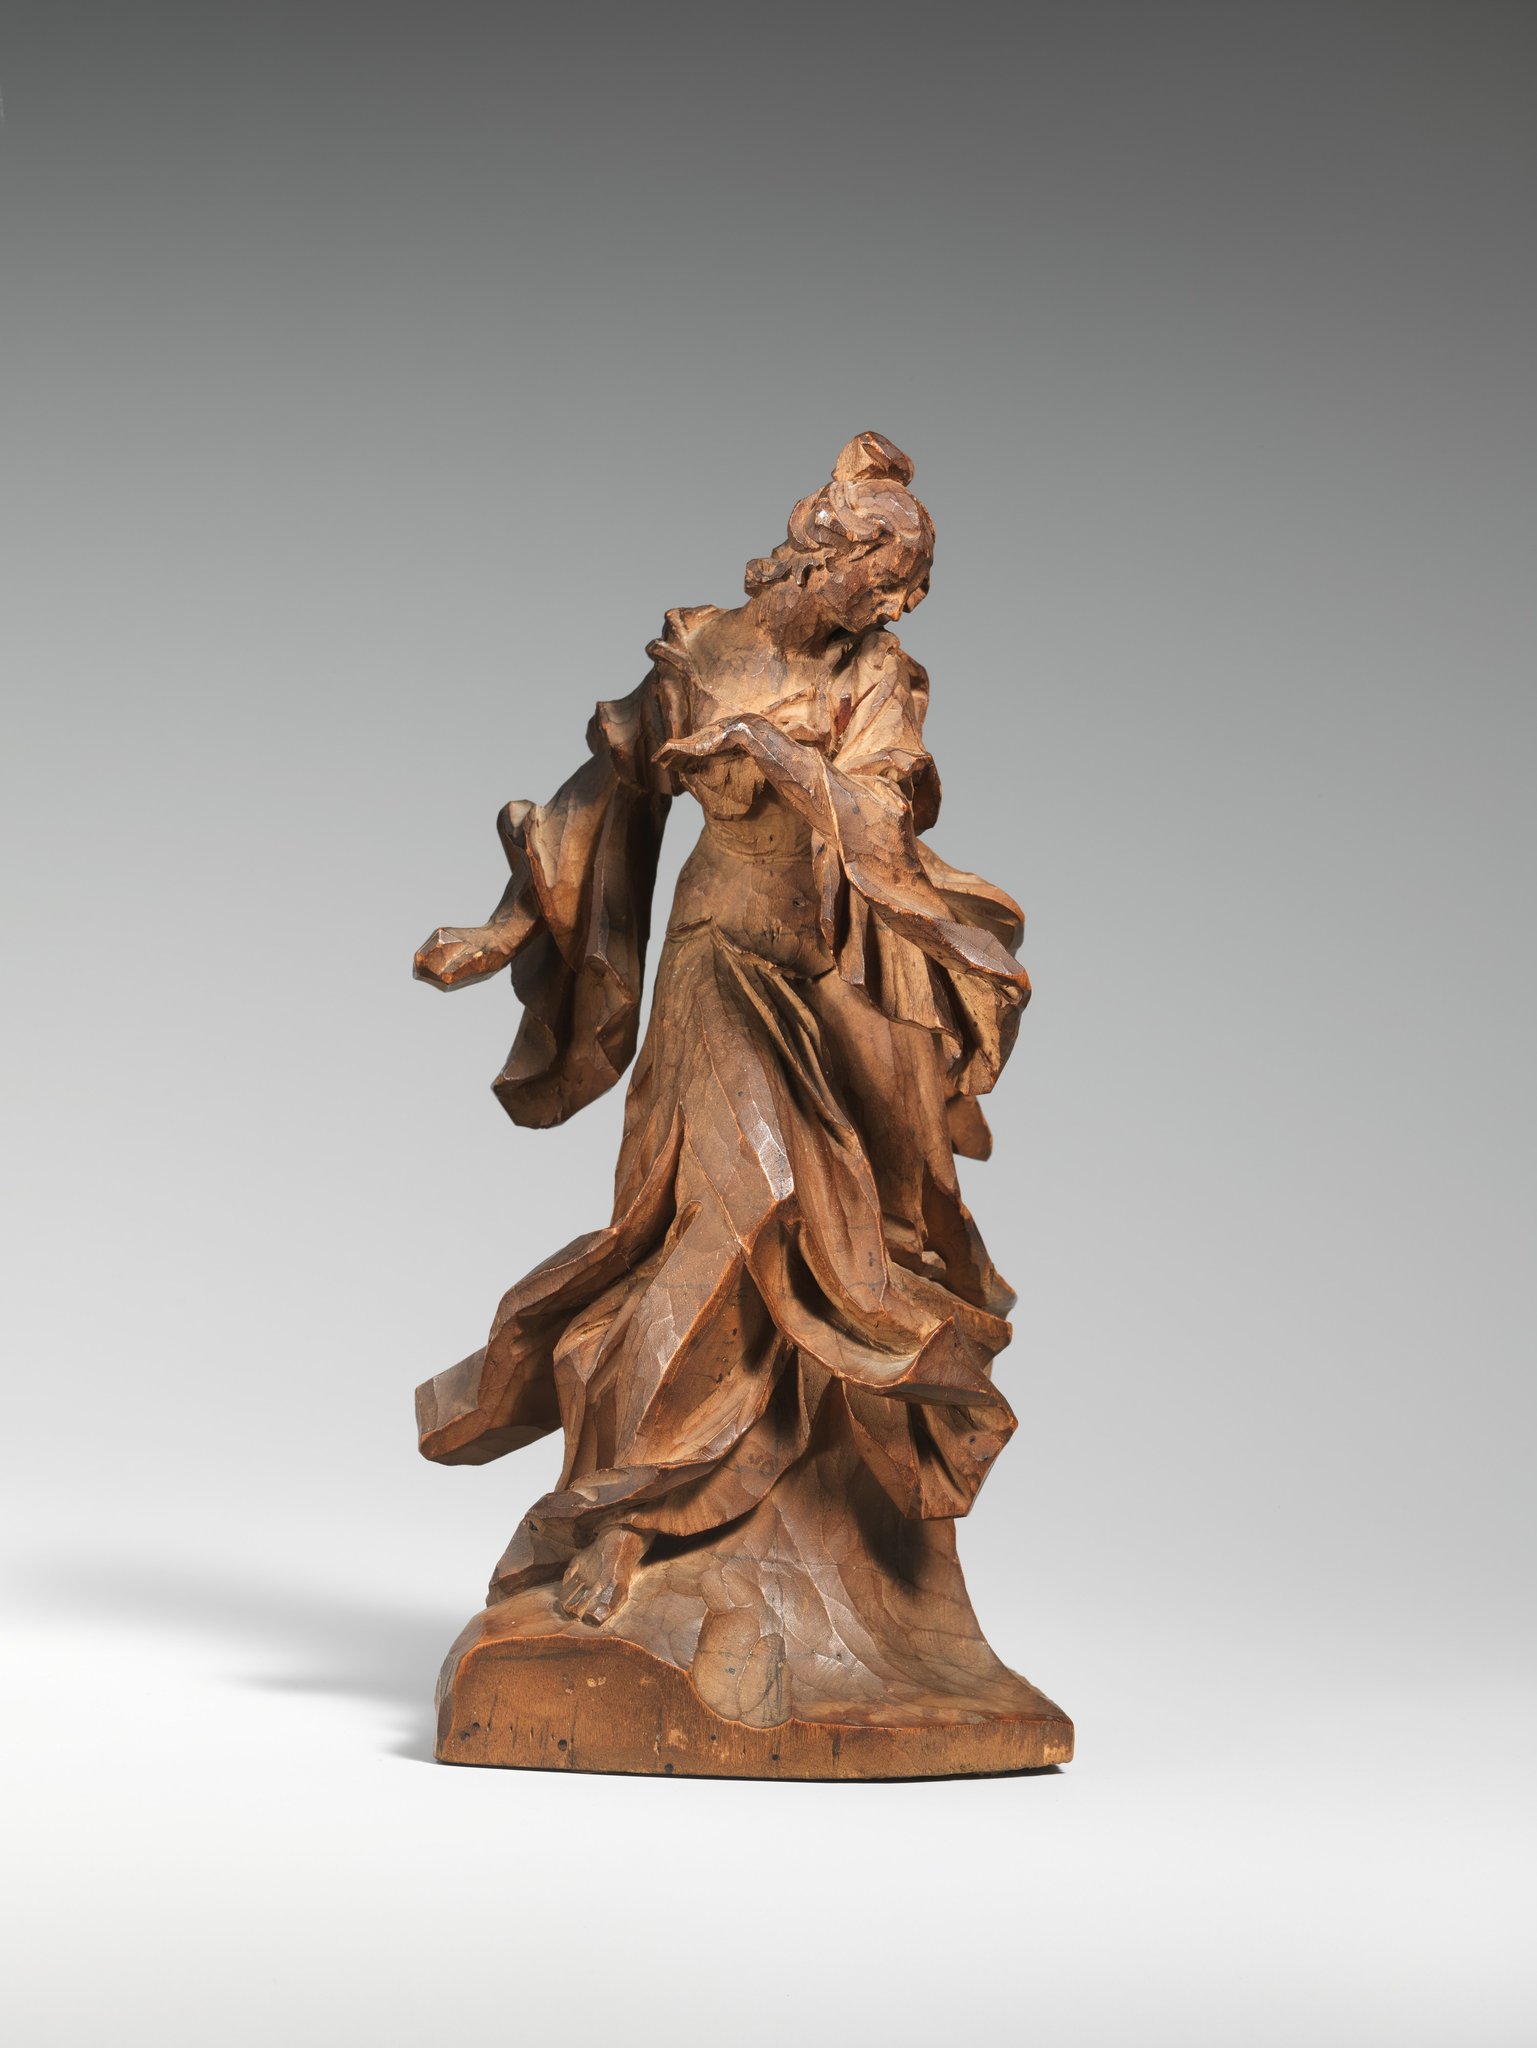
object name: statuette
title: Model for the so-called "Female Saint of Starnberg"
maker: ignaz günther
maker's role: maker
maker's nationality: german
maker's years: 1725-1775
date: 1755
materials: wood, pencil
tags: women,saints